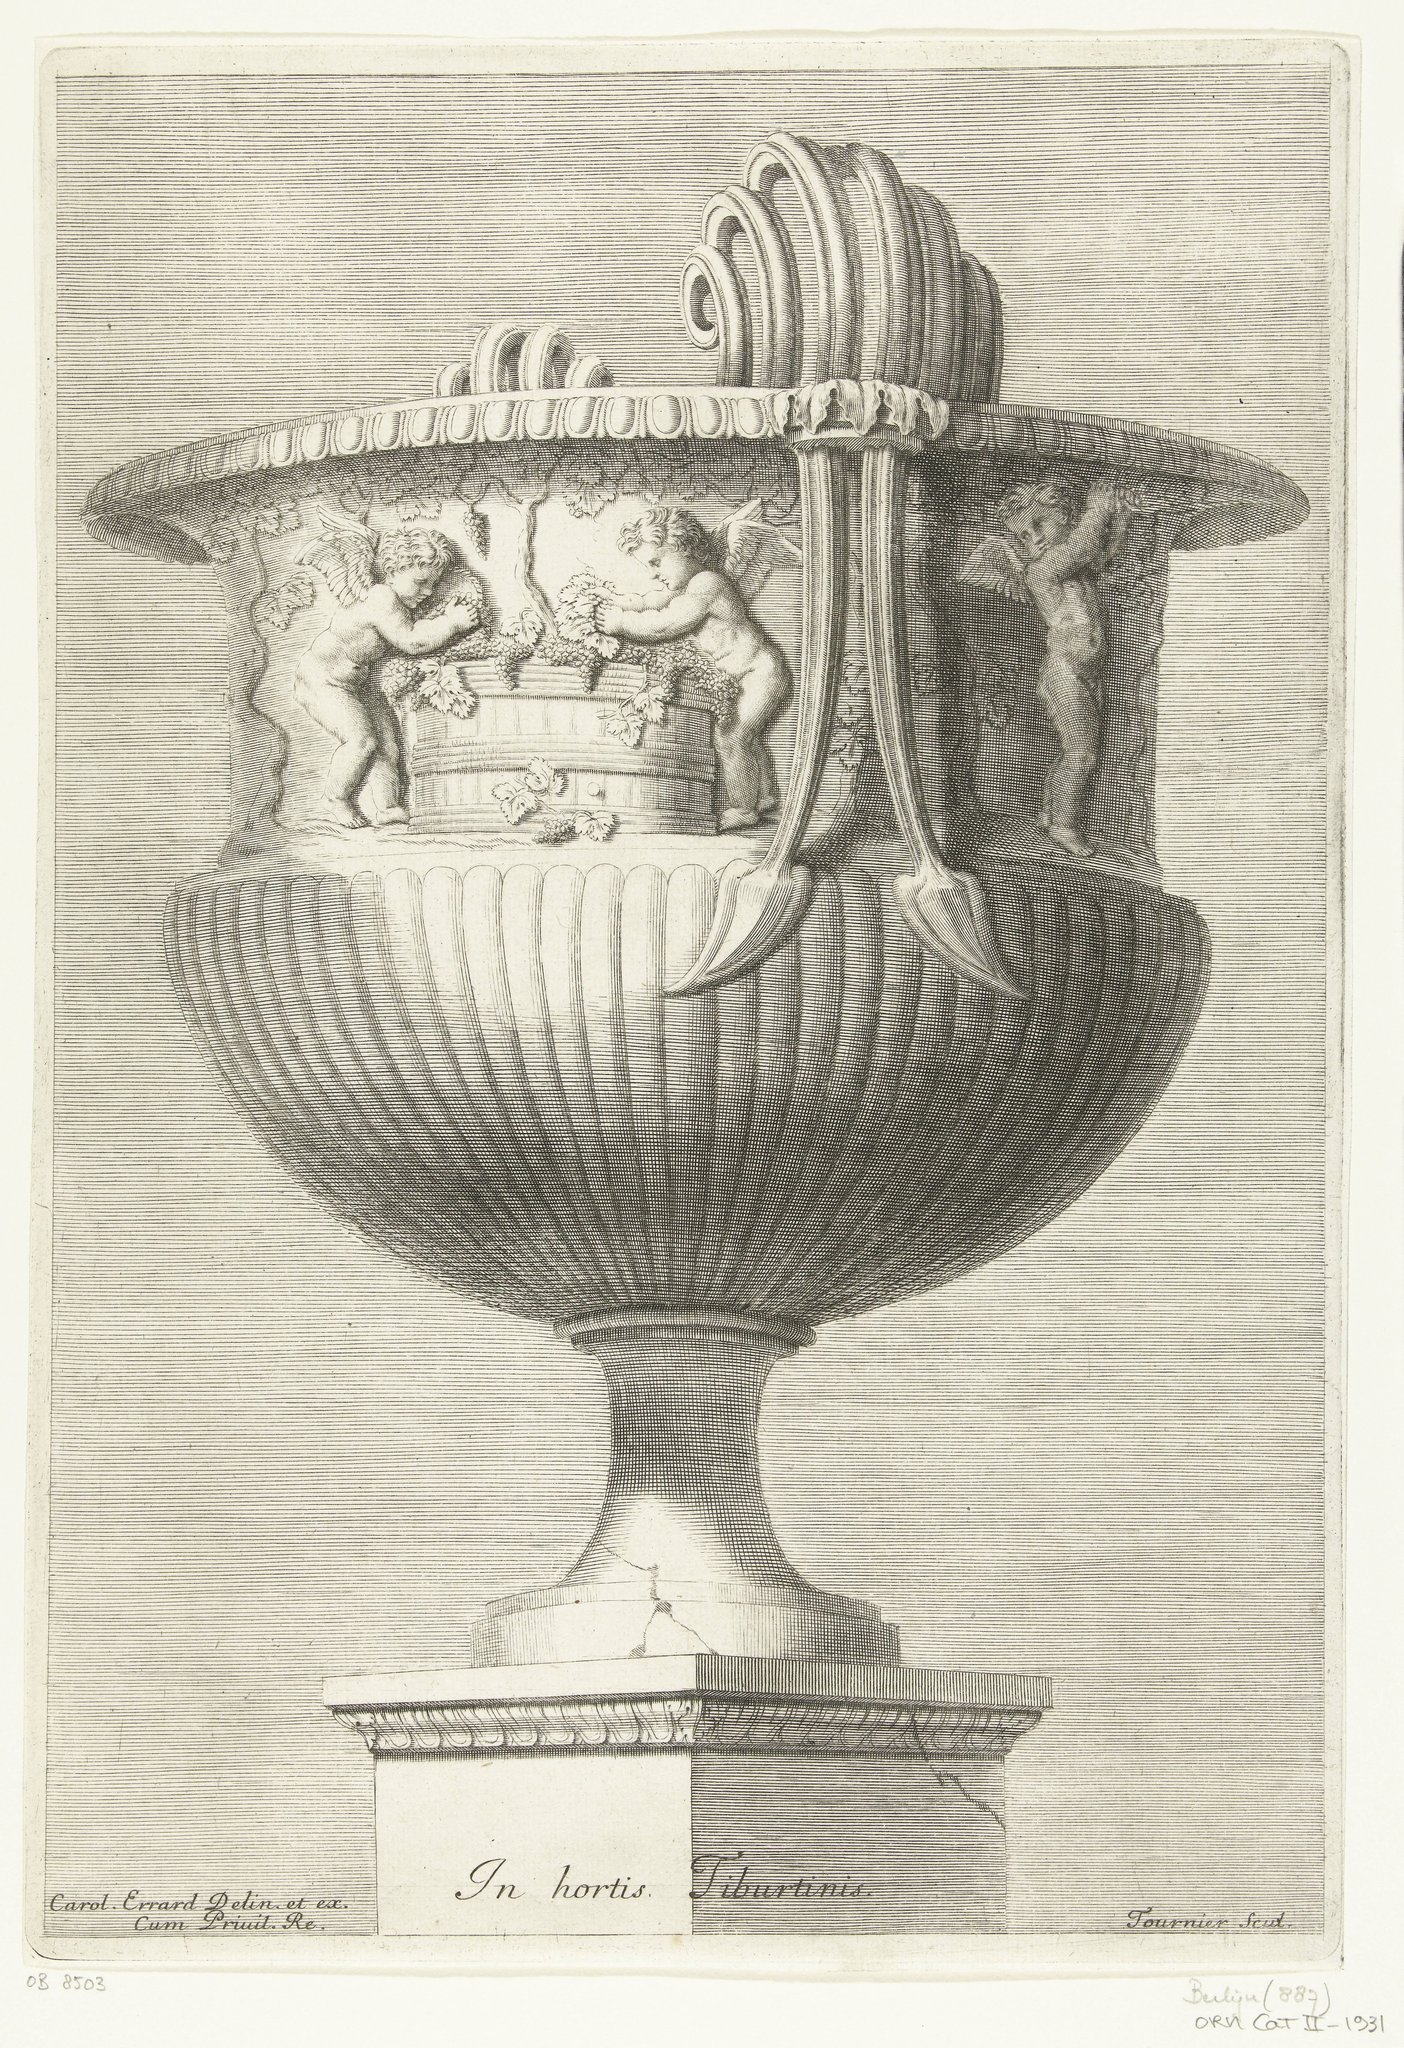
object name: print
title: In hortis Tiburtinis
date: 1650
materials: paper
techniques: engraving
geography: france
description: De vaas heeft een dubbel handvat dat uitloopt in een open spiraalvorm, op het fries staan putti die druiven plukken. Uit serie van 13 bladen.